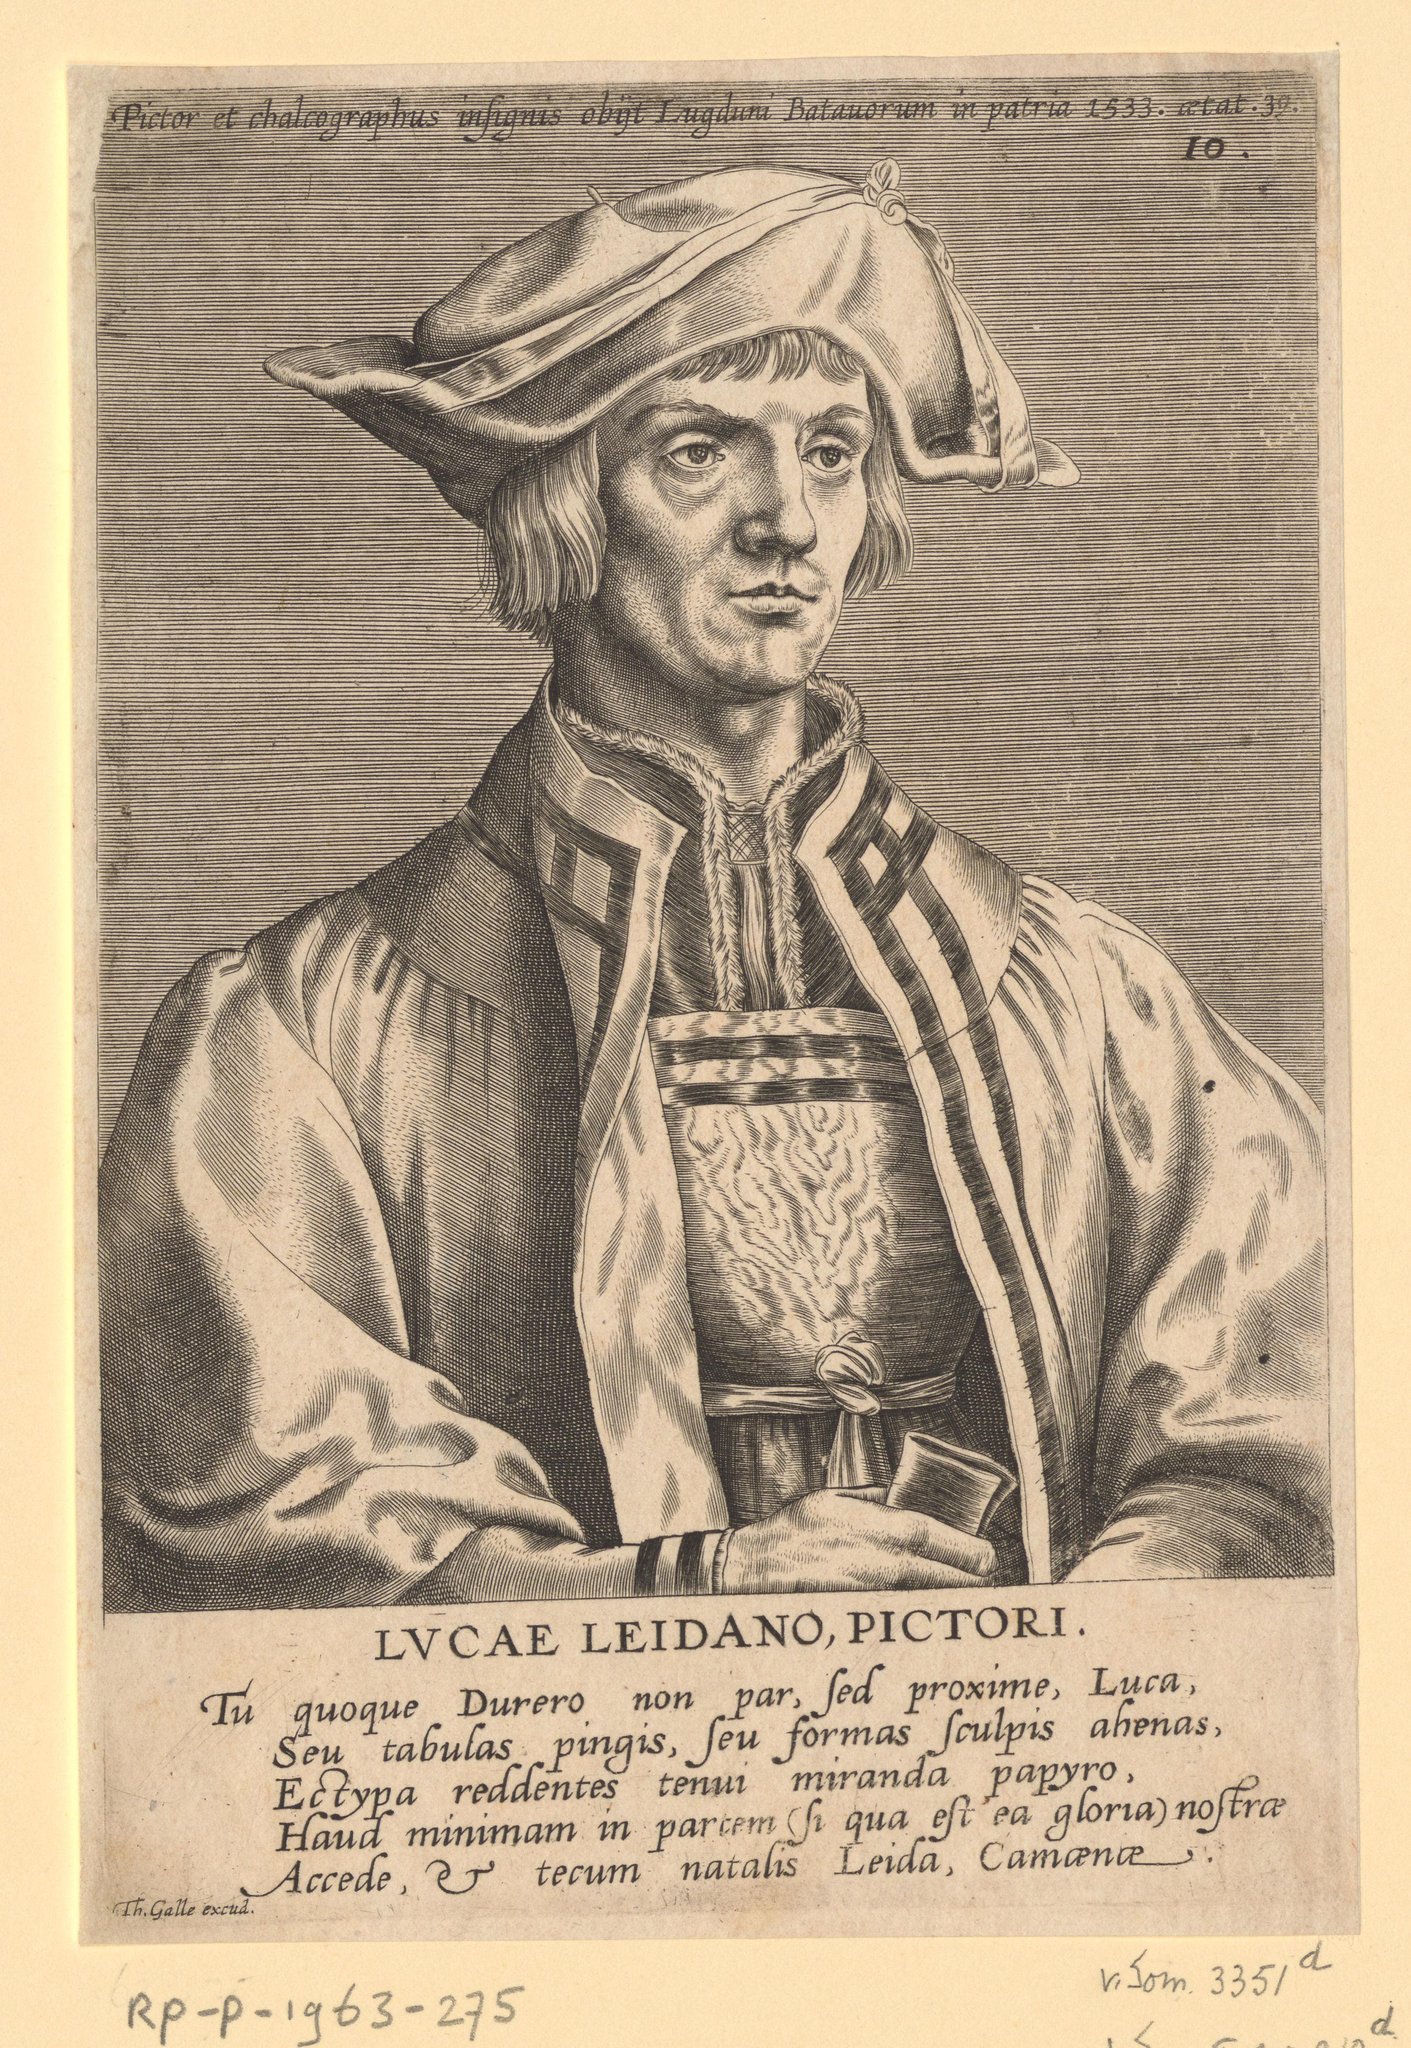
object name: print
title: Portretten van schilders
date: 1600-1633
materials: paper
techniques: engraving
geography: antwerp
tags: leiden, painter, print maker, draughtsman, lucas van leyden, historical persons, portrait, self-portrait of painter, portrait, self-portrait of graphic artist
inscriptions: collector's mark: Lugt 2228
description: Boven het portret een regel in het Latijn, onder het portret een vijfregelig Latijns onderschrift. Rechtsboven genummerd: 10.